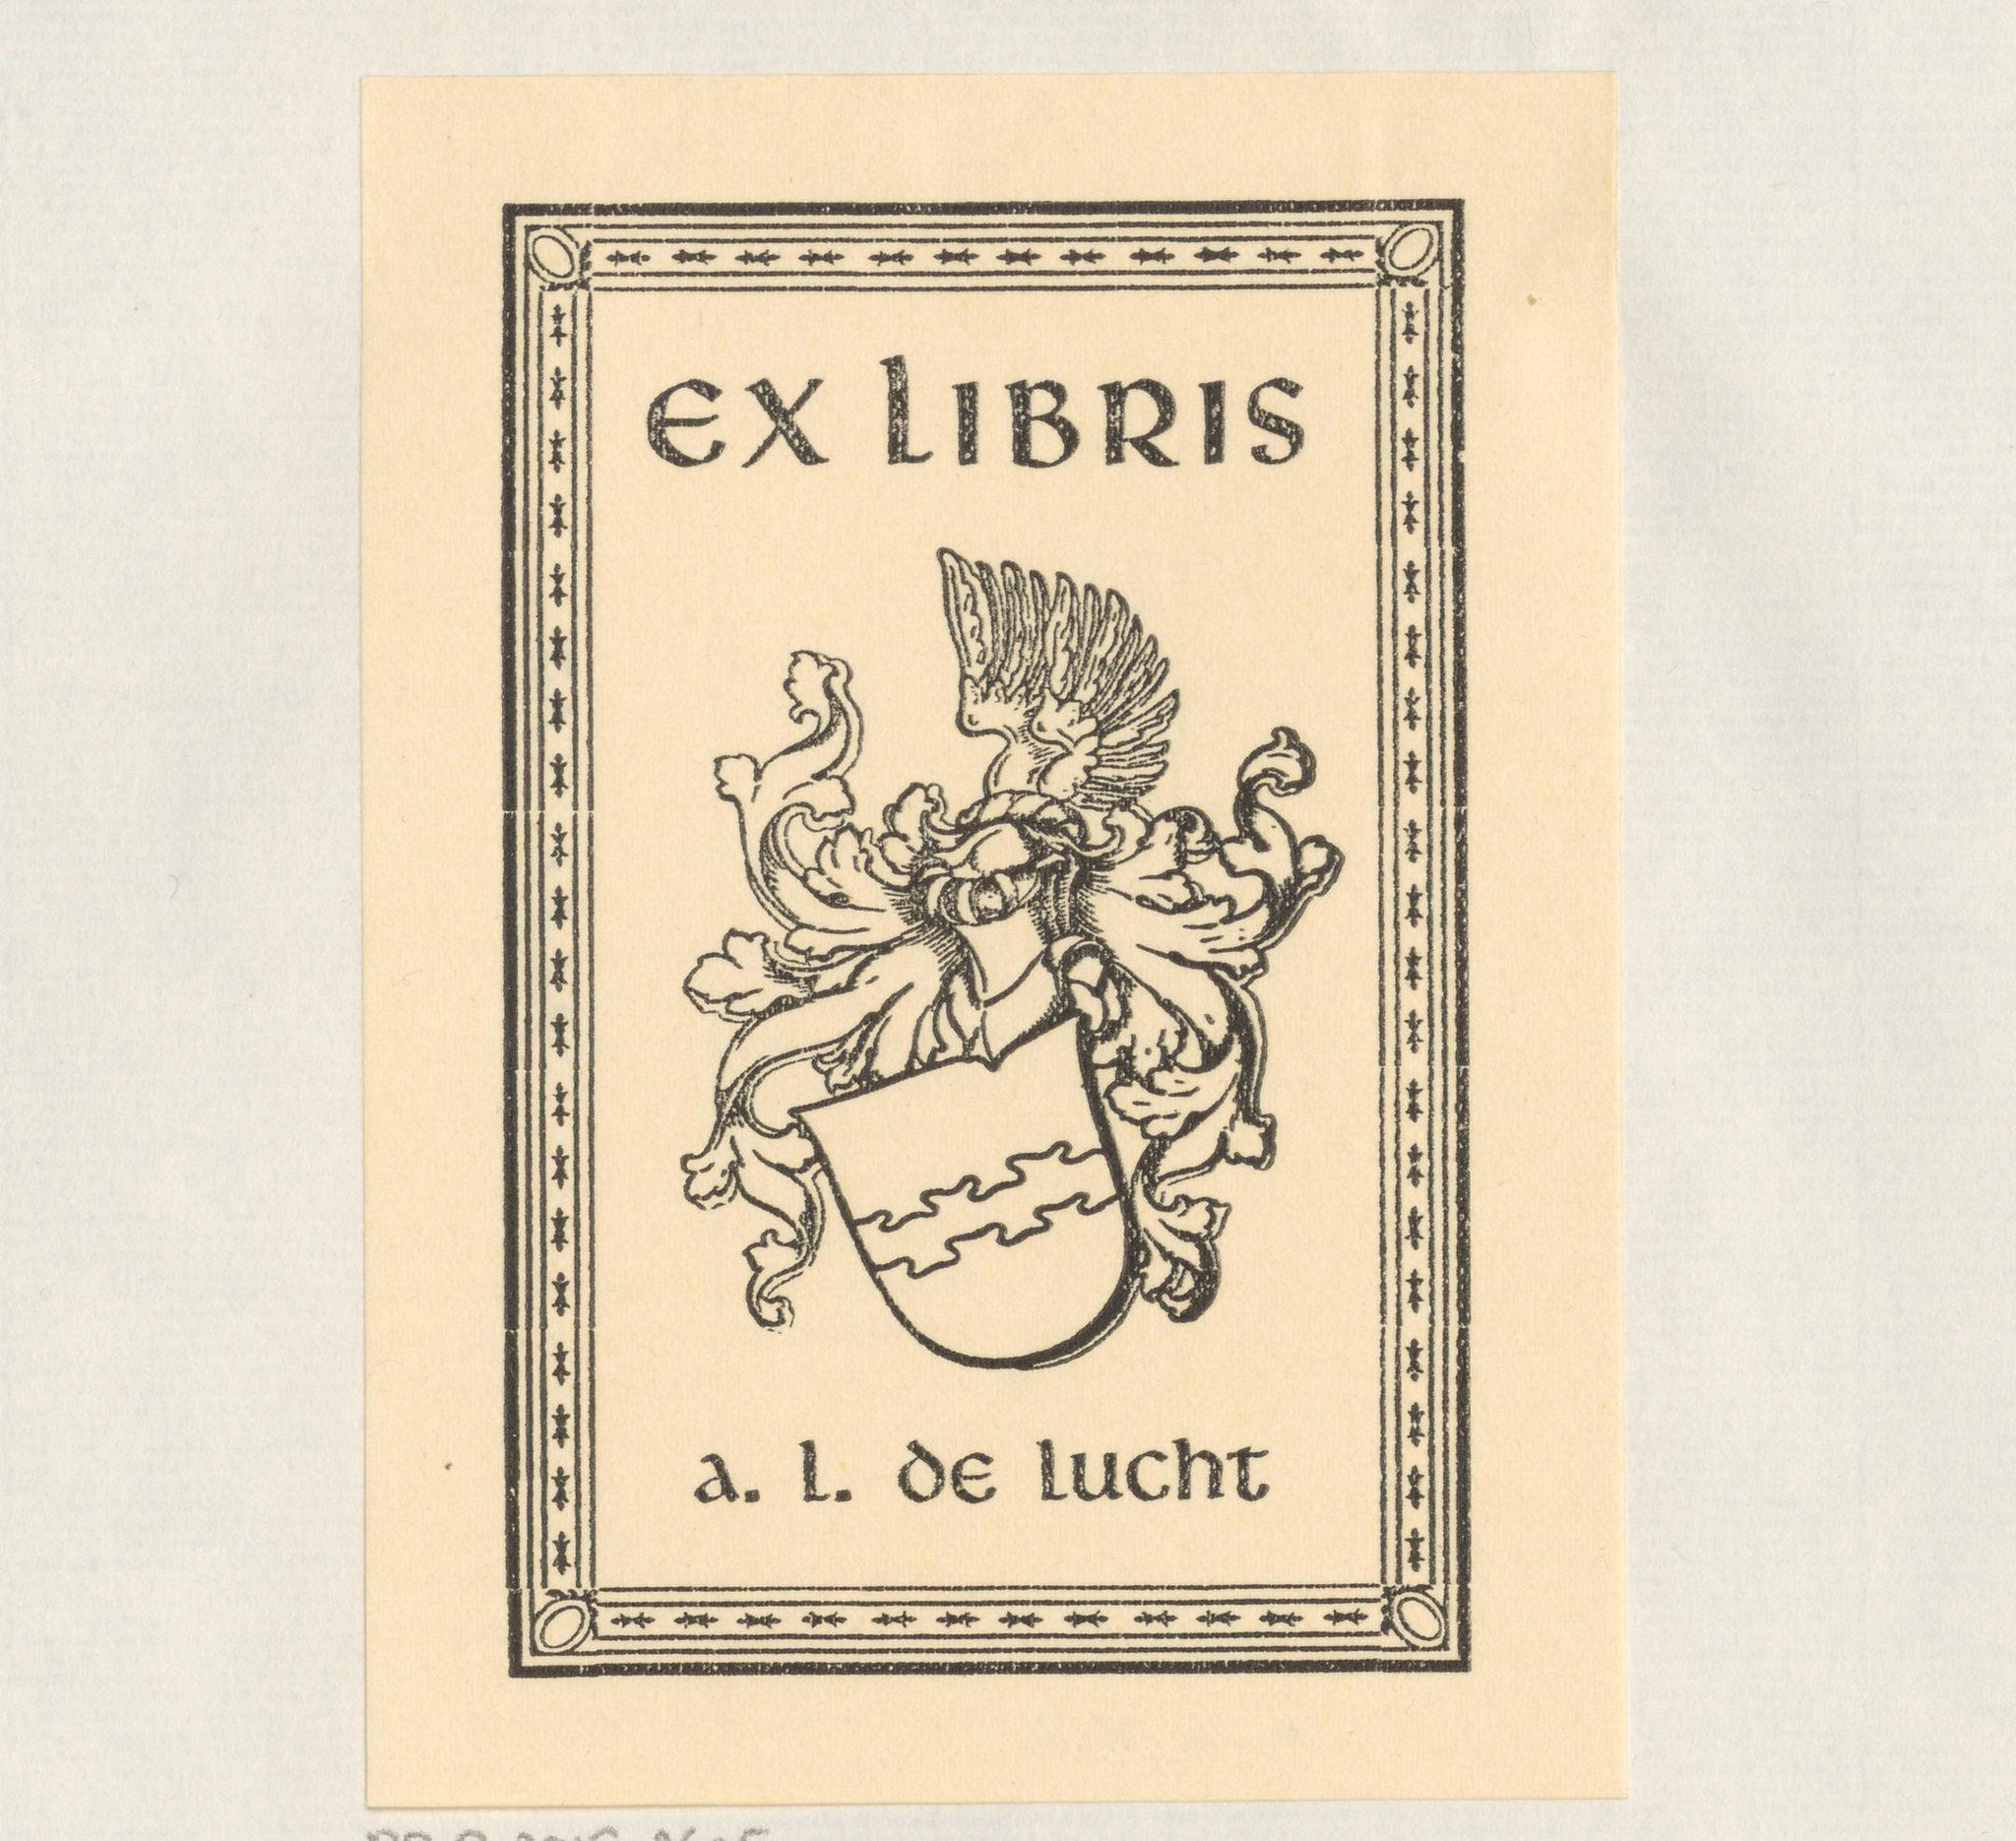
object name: bookplate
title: Ex libris van A.L. de Lucht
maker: Anonymous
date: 1946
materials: paper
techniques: printing block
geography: netherlands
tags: armorial bearing, heraldry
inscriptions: inscription: ‘Cl 1946’